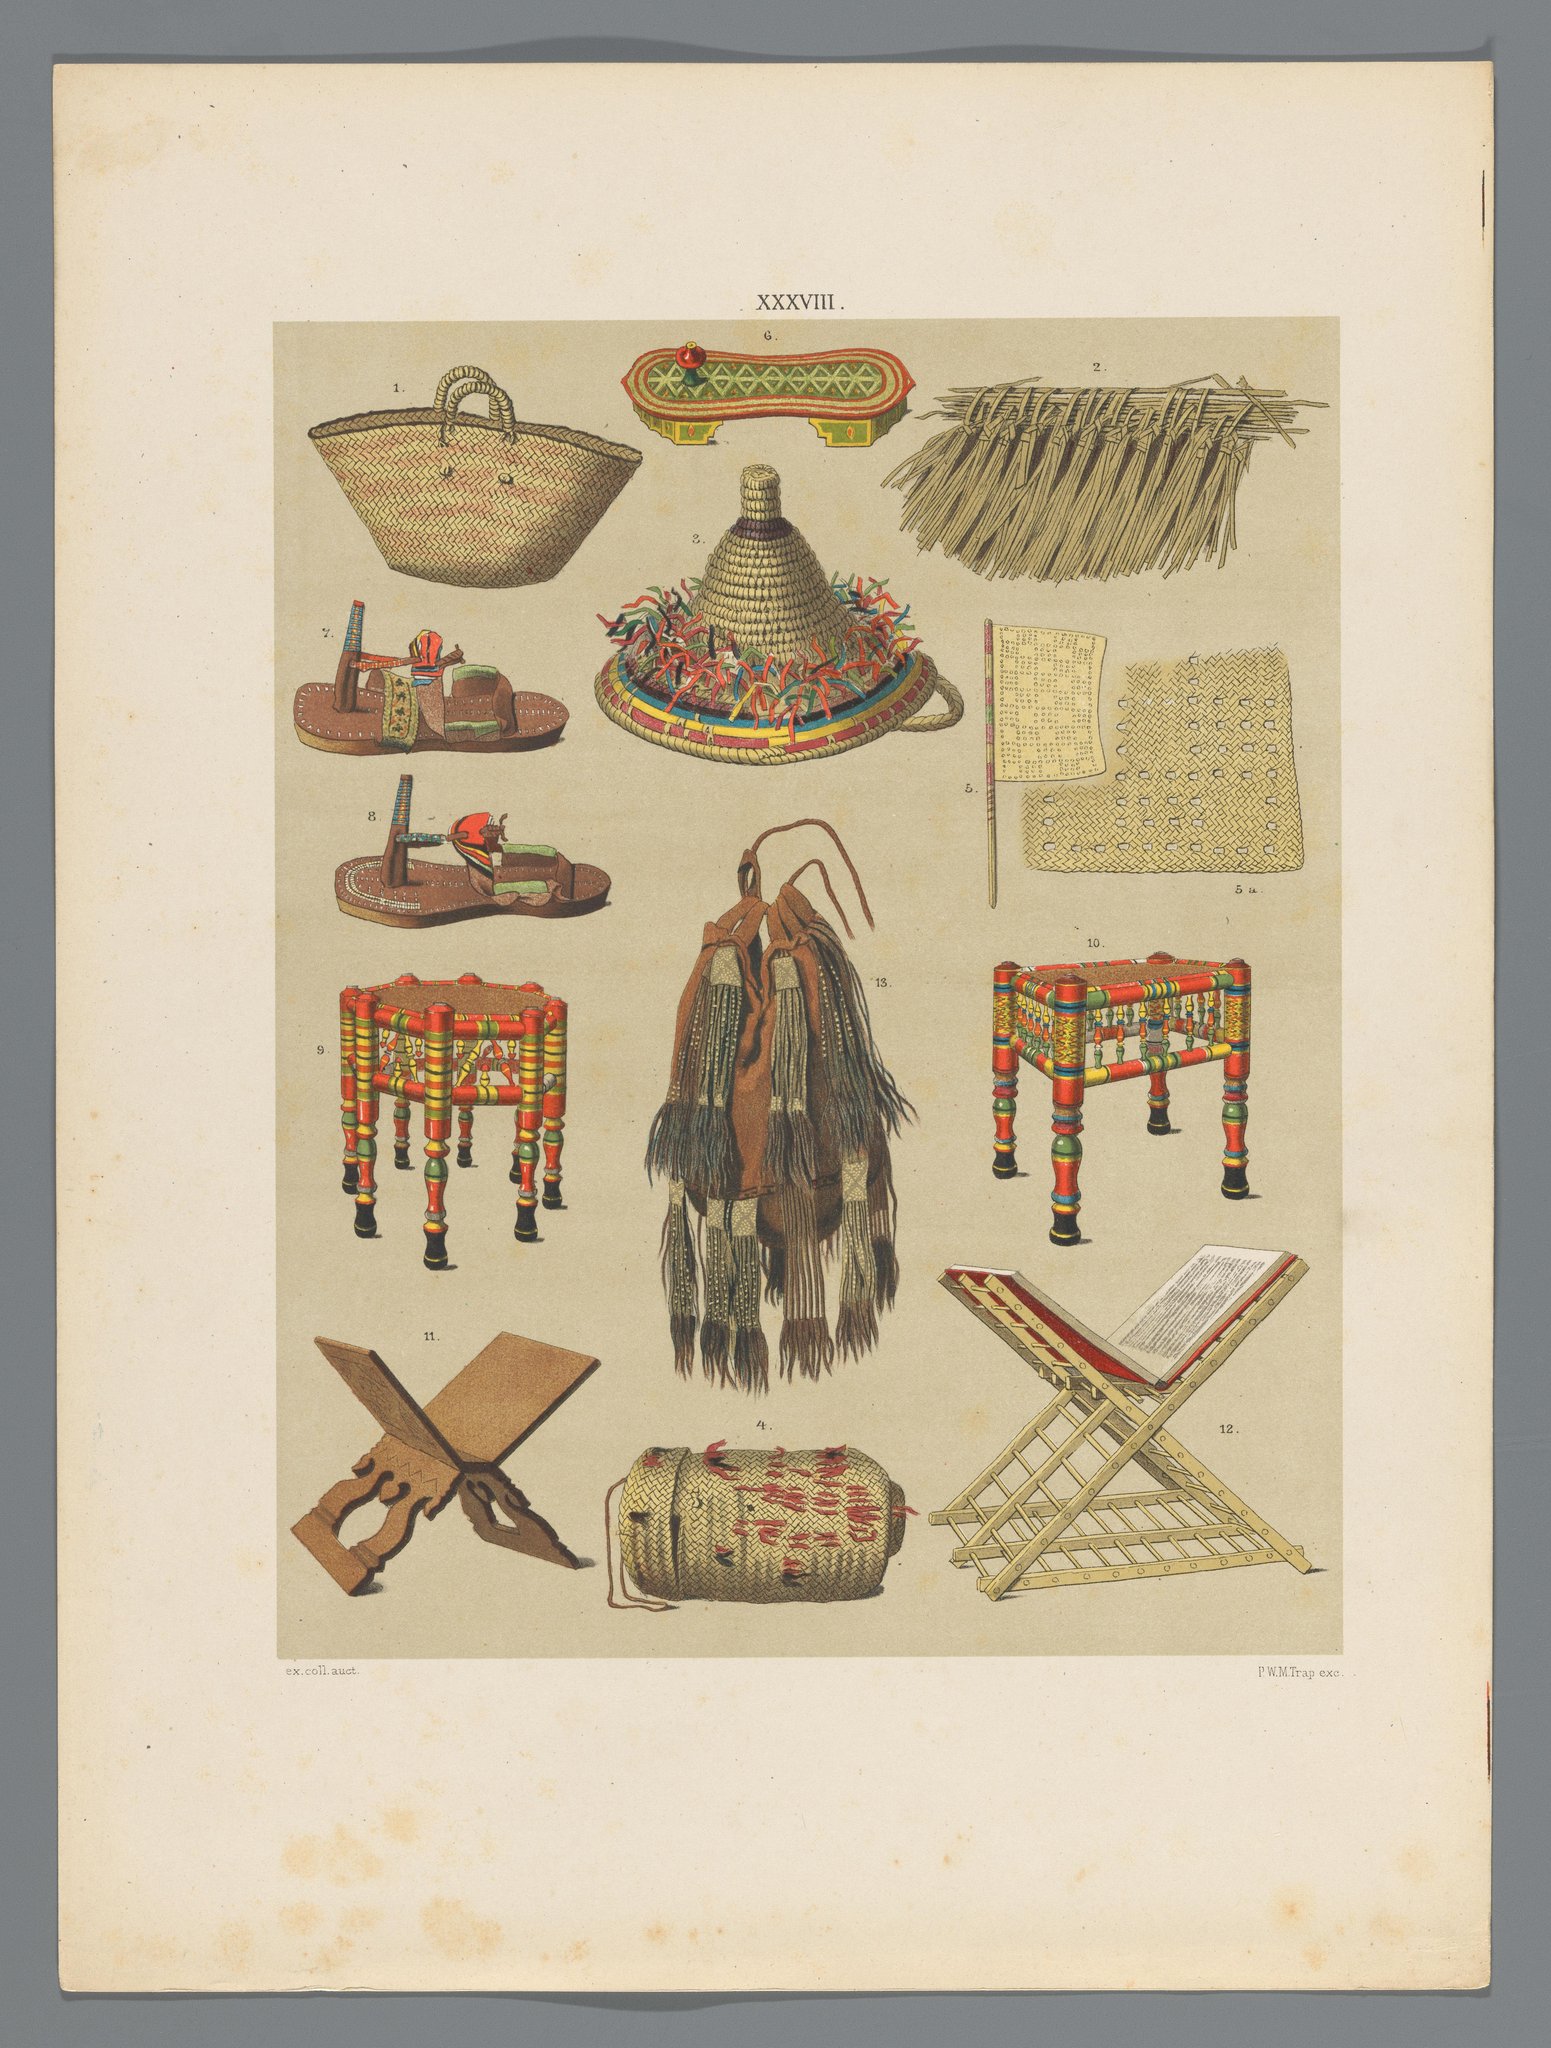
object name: print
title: Gebruiksvoorwerpen uit Mekka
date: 1883-1888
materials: paper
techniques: lithograph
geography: leiden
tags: still life of miscellaneous objects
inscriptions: number: ‘XXXVIII.’